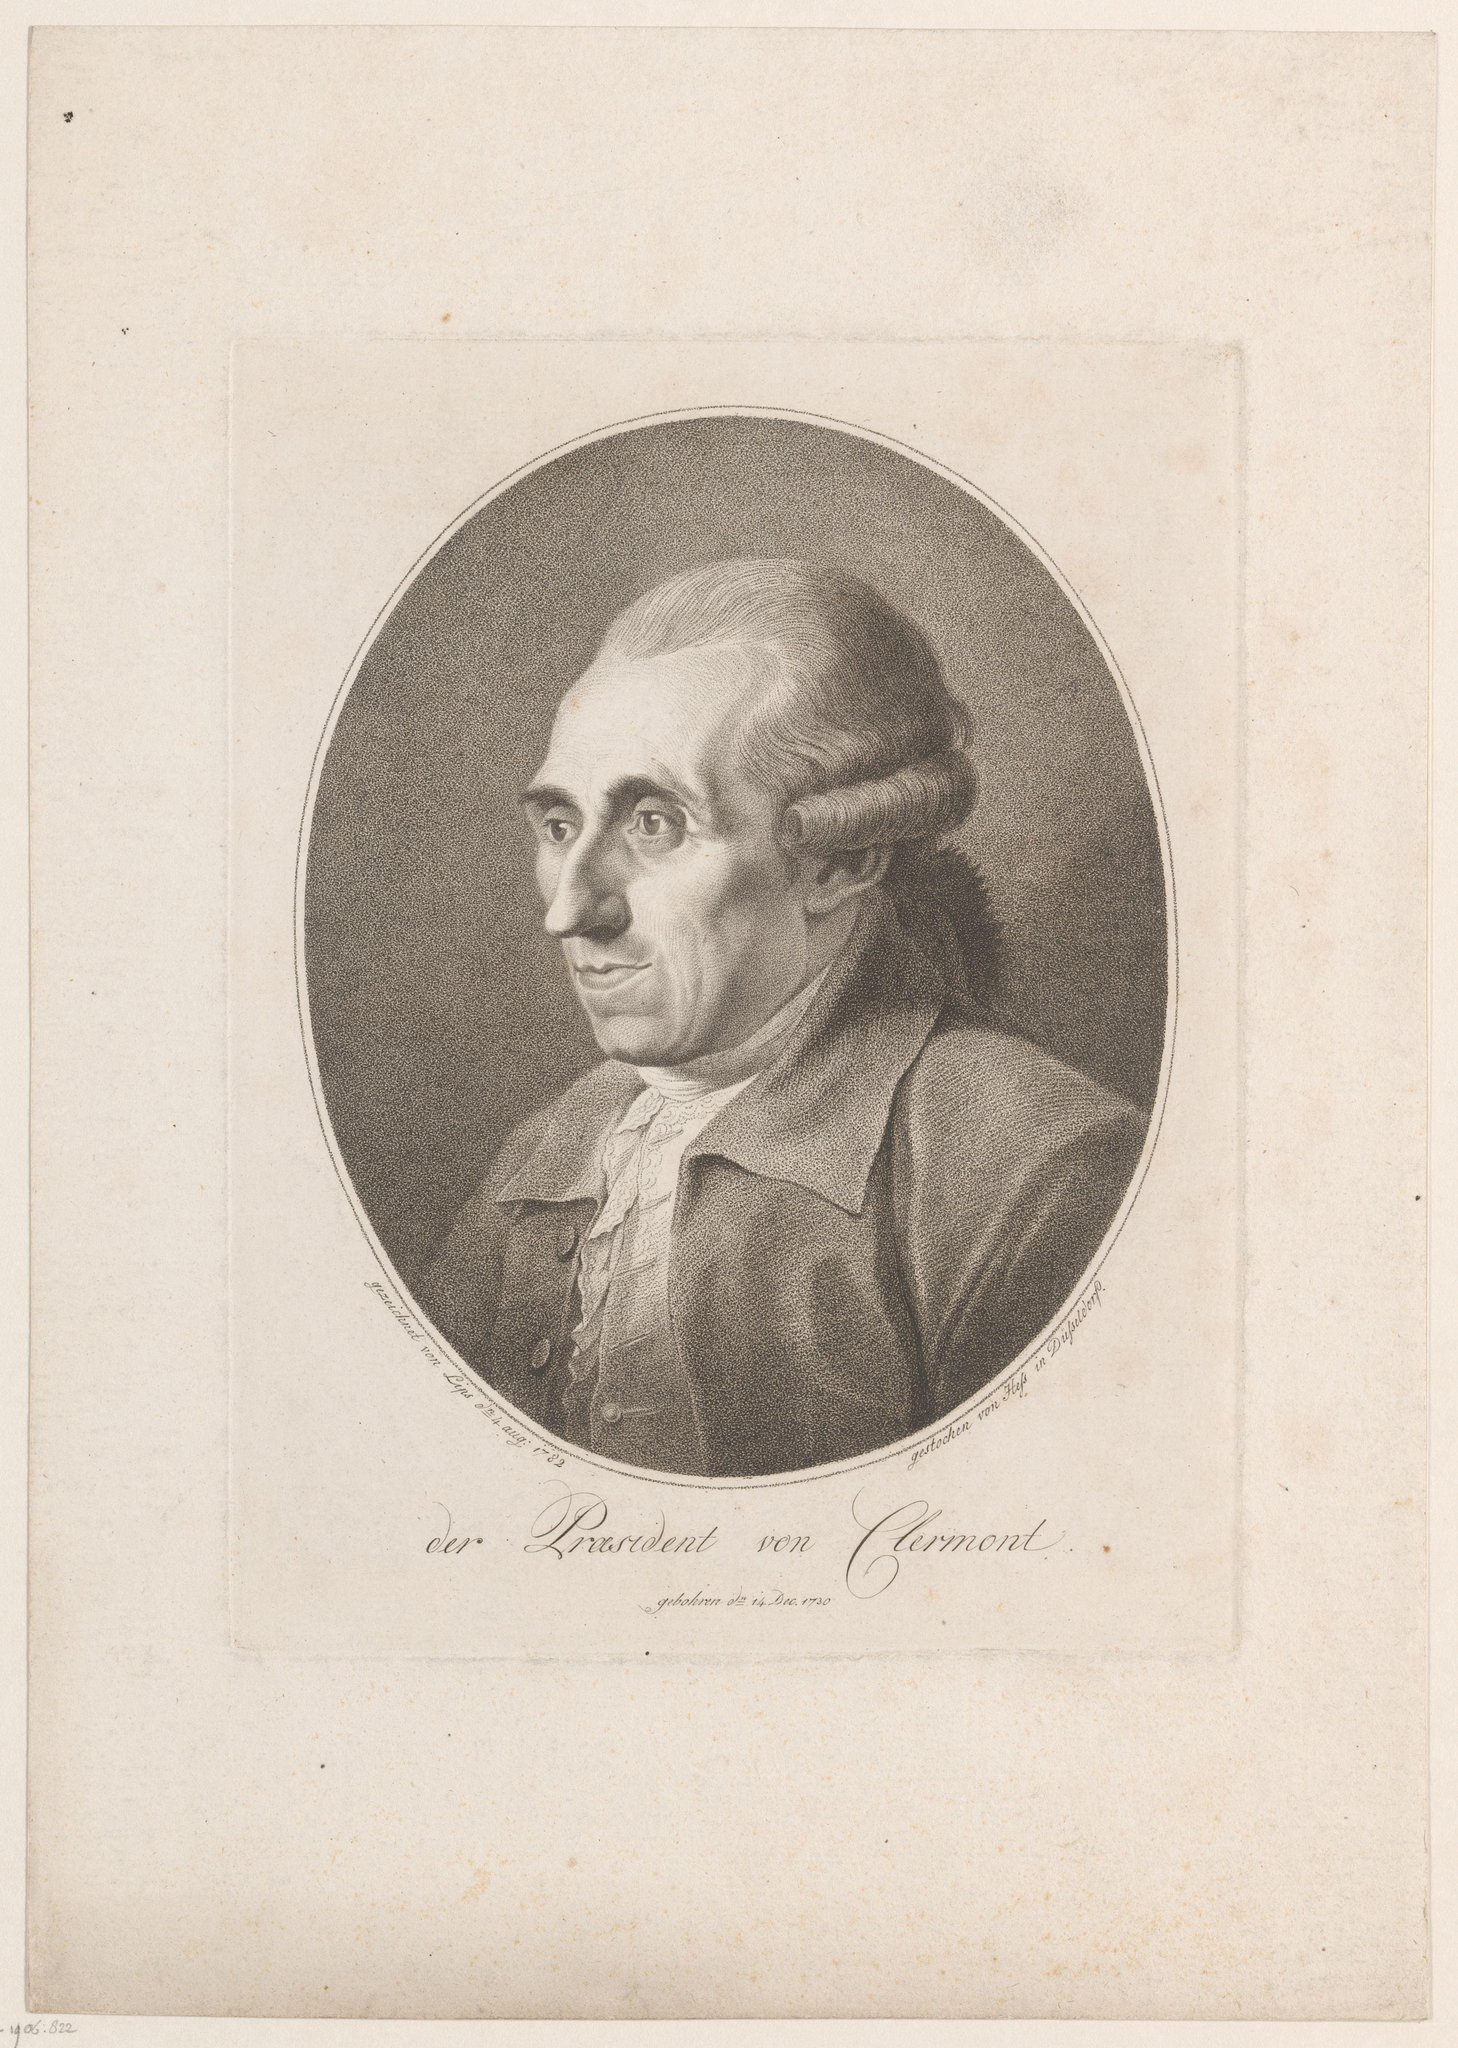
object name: print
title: Portret van Theodor Christian Clermont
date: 1782-1828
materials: paper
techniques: engraving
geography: dusseldorf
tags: historical persons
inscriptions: collector's mark: Lugt 2228